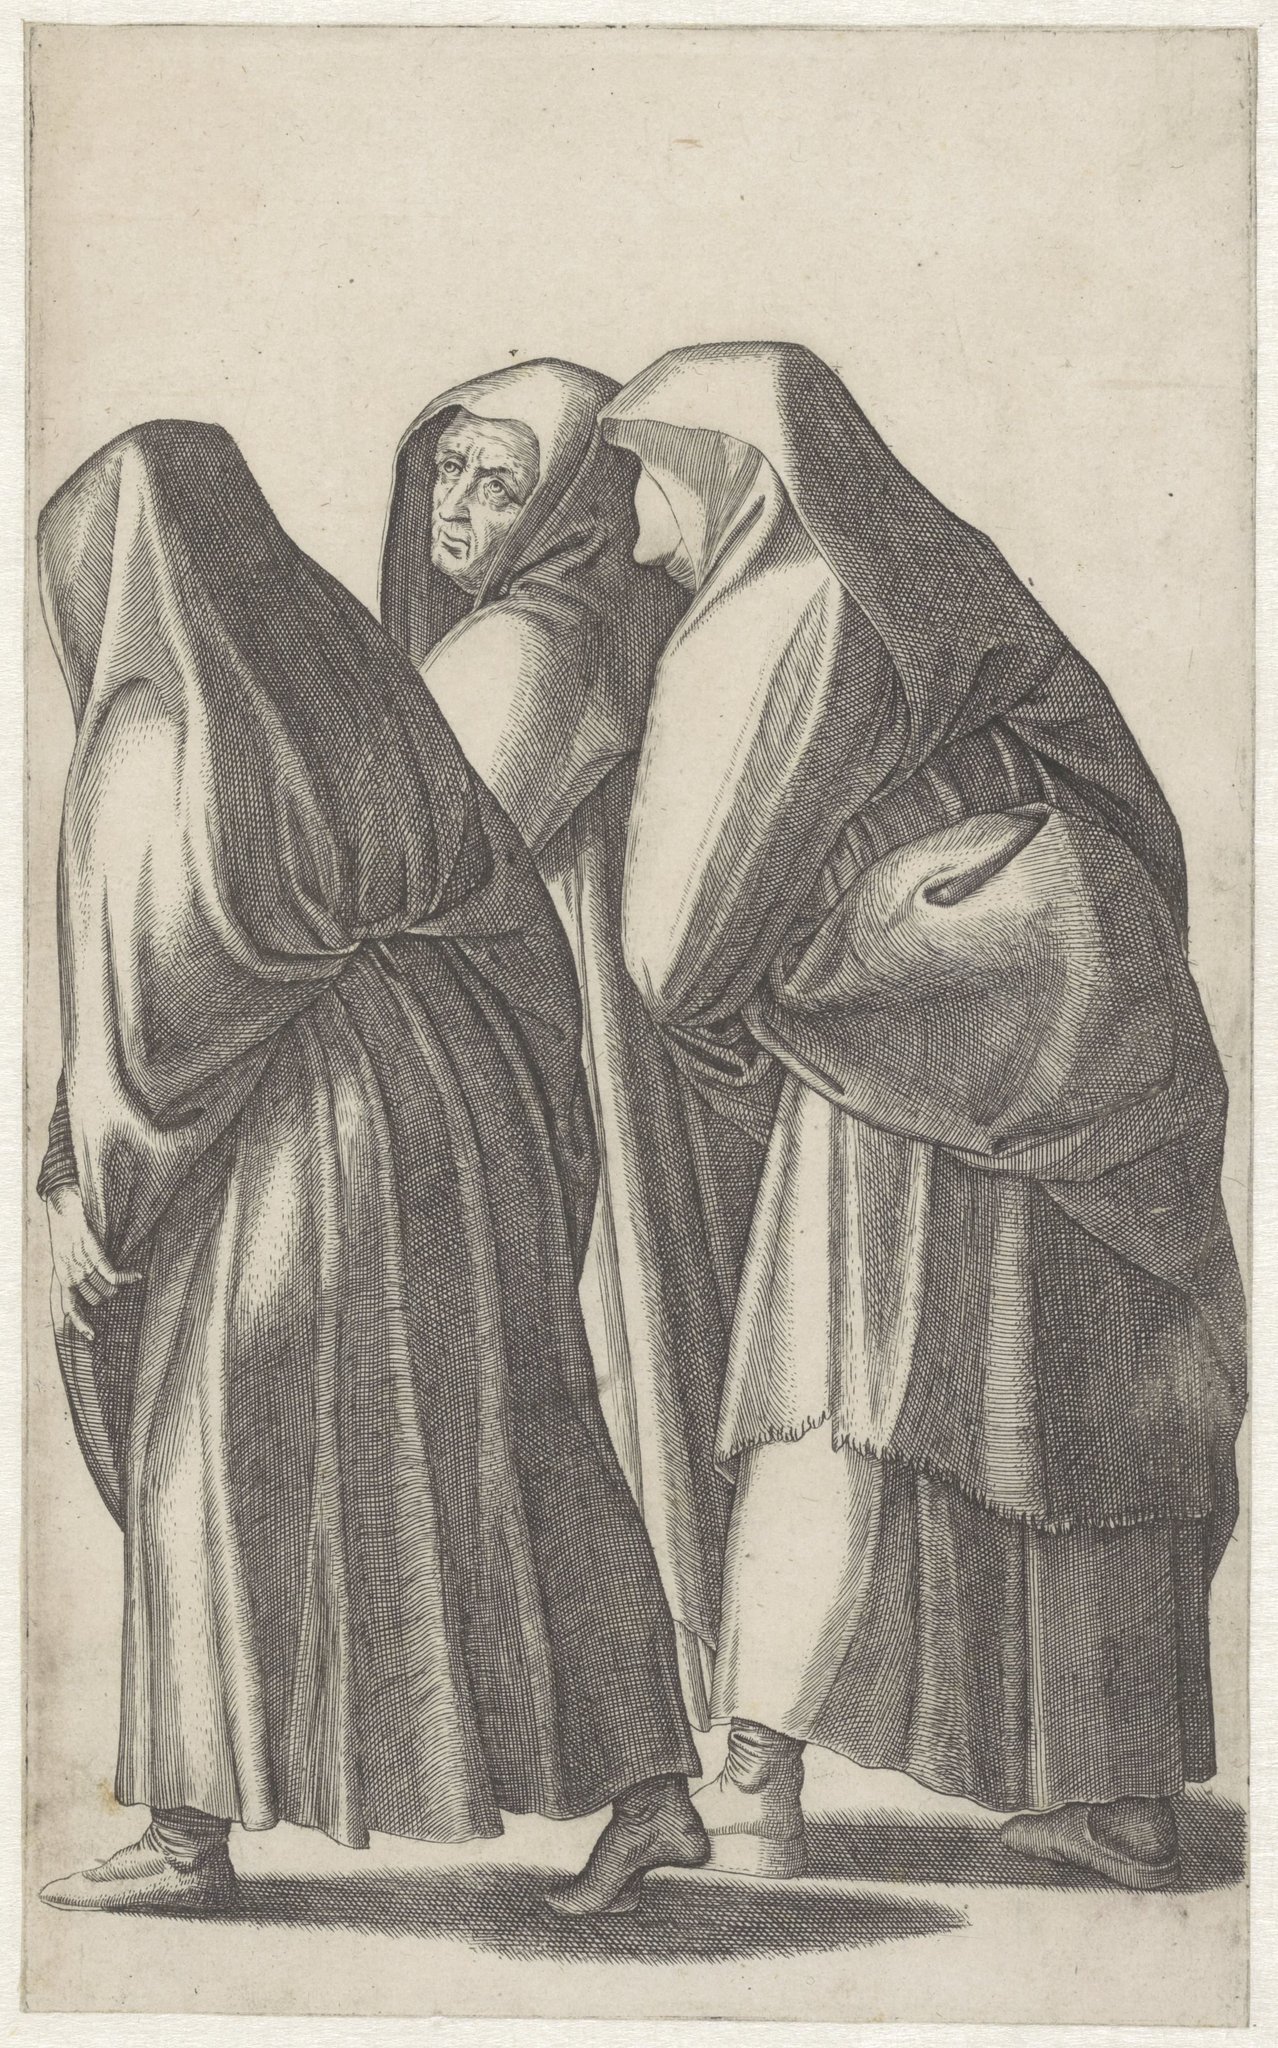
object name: print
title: Heilige vrouwen op weg naar het graf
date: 1500-1536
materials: paper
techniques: engraving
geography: italy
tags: the holy women (the three maries) on their way to or at the tomb, to anoint christ's body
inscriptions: collector's mark: Lugt 12, collector's mark: ‘F Rechberger 1801’ Lugt 2133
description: De drie heilige vrouwen, alle drie gesluierd, lopen naar links. Alleen van de middelste vrouw is het gezicht zichtbaar.